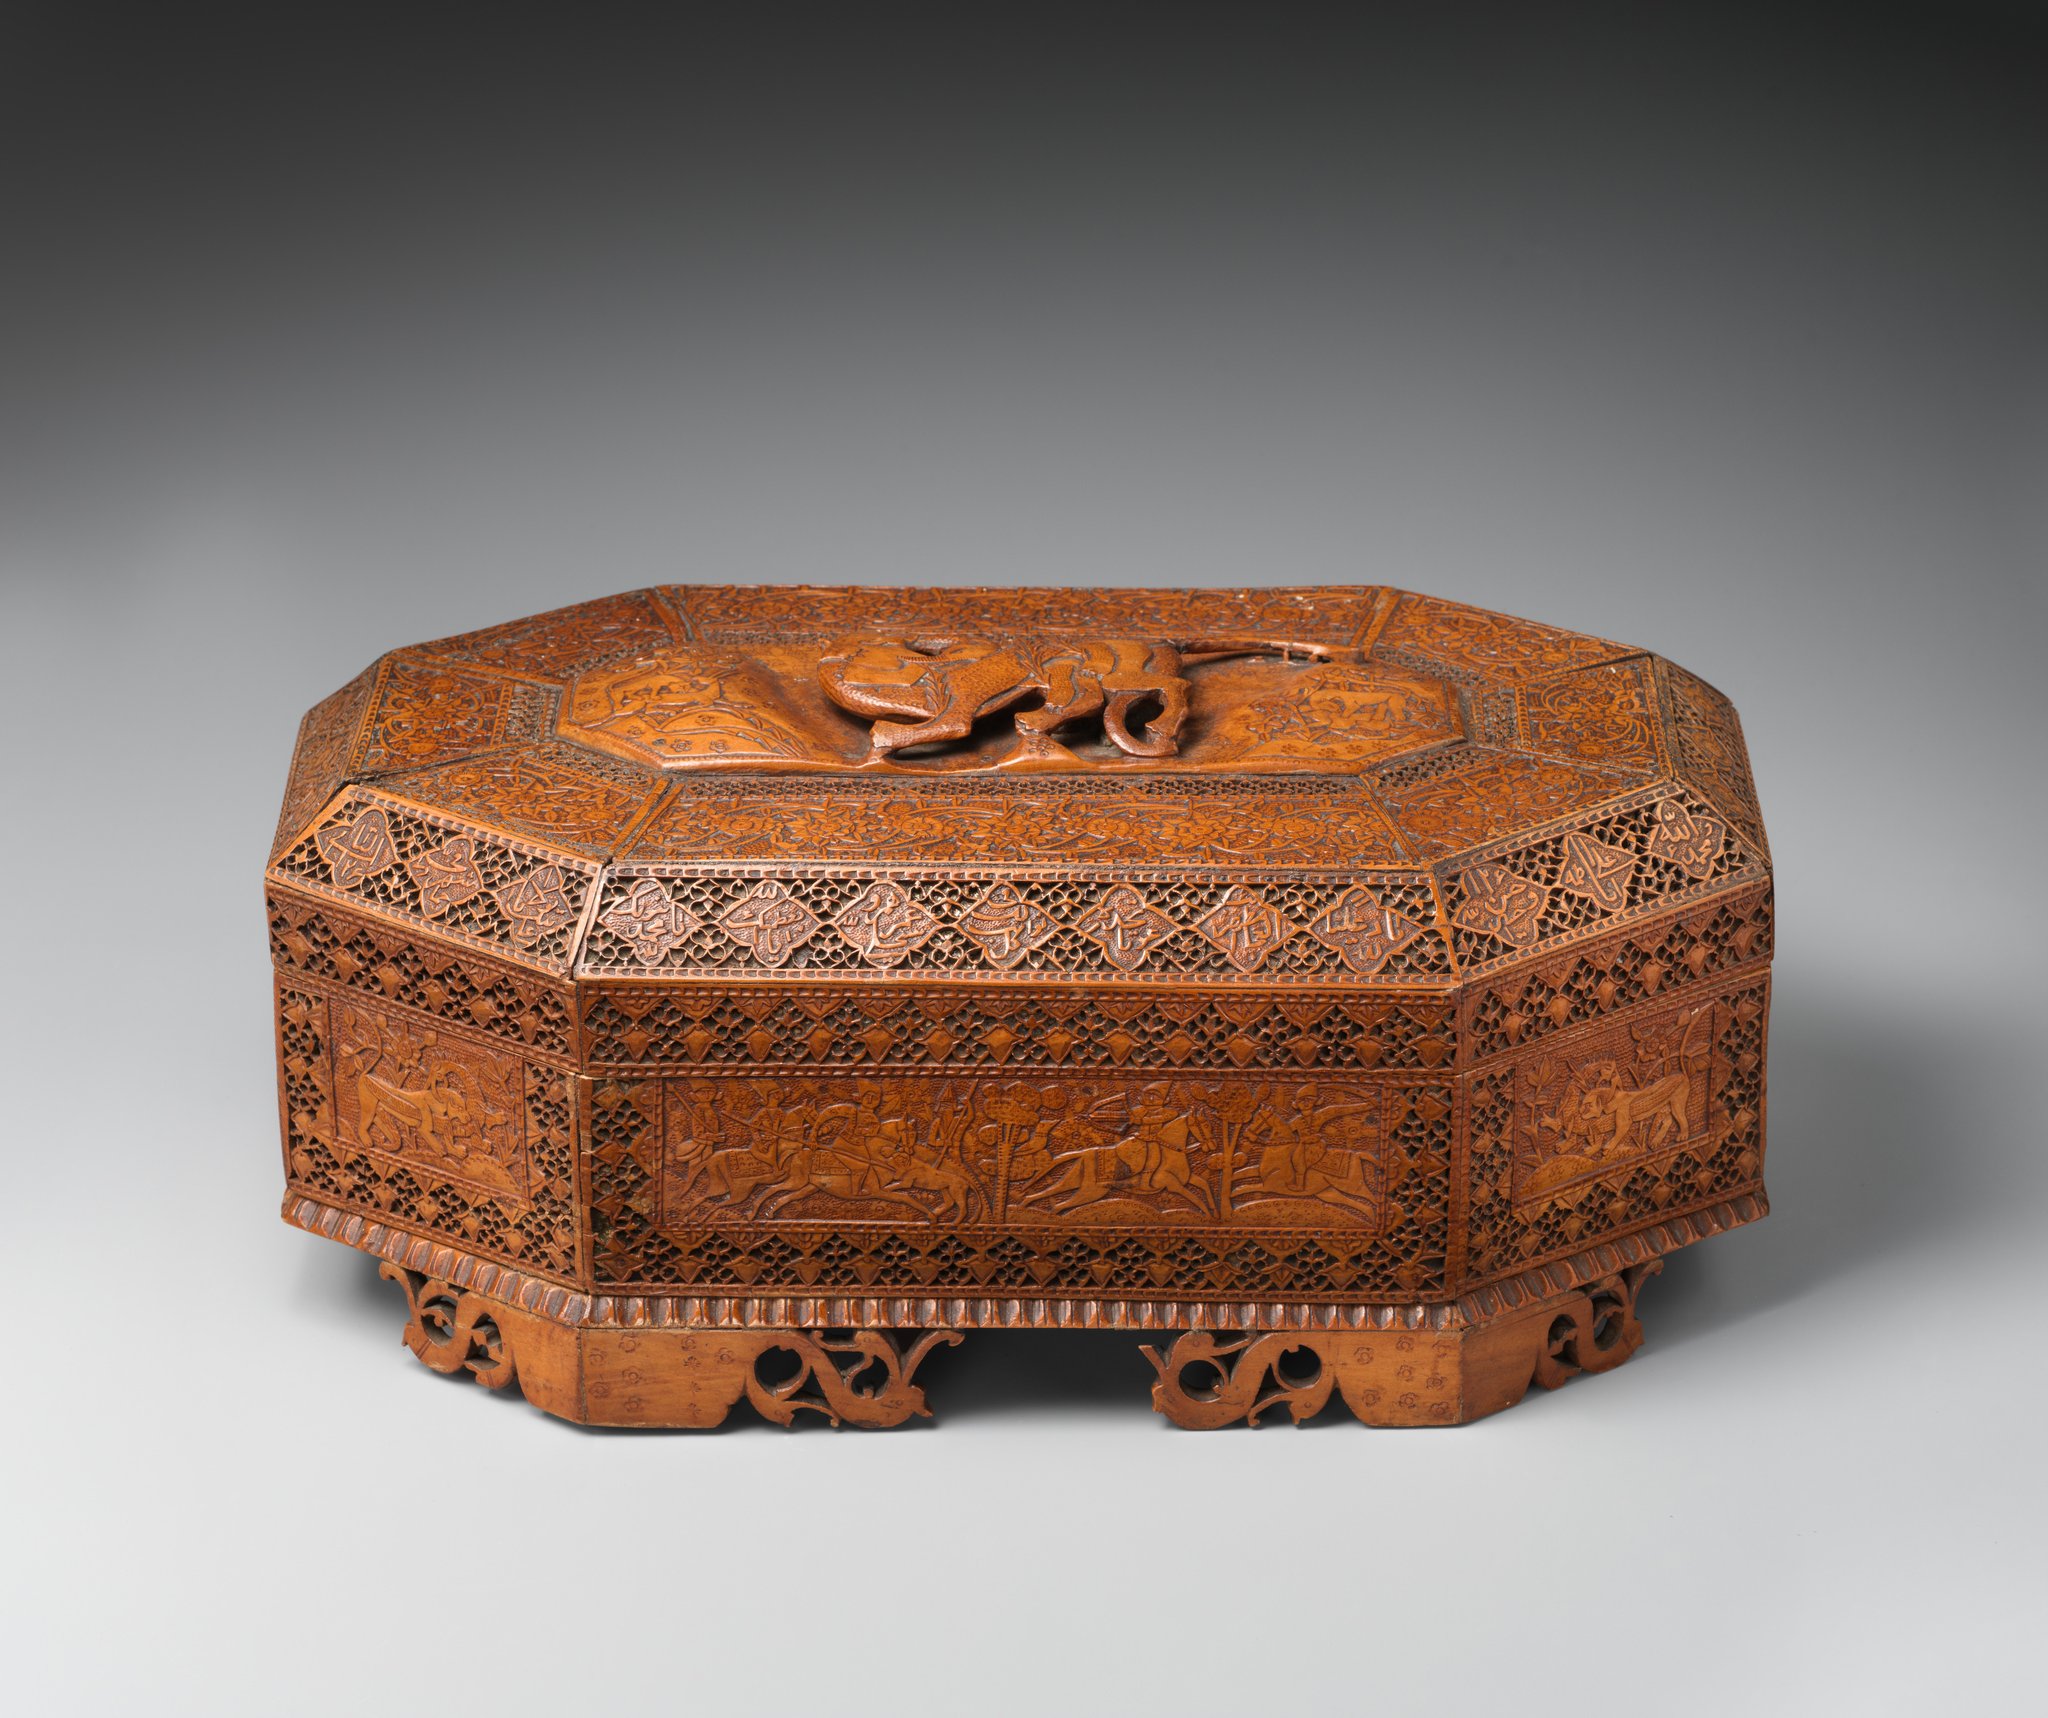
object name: box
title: Carved Wooden Box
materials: silk, wood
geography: iran